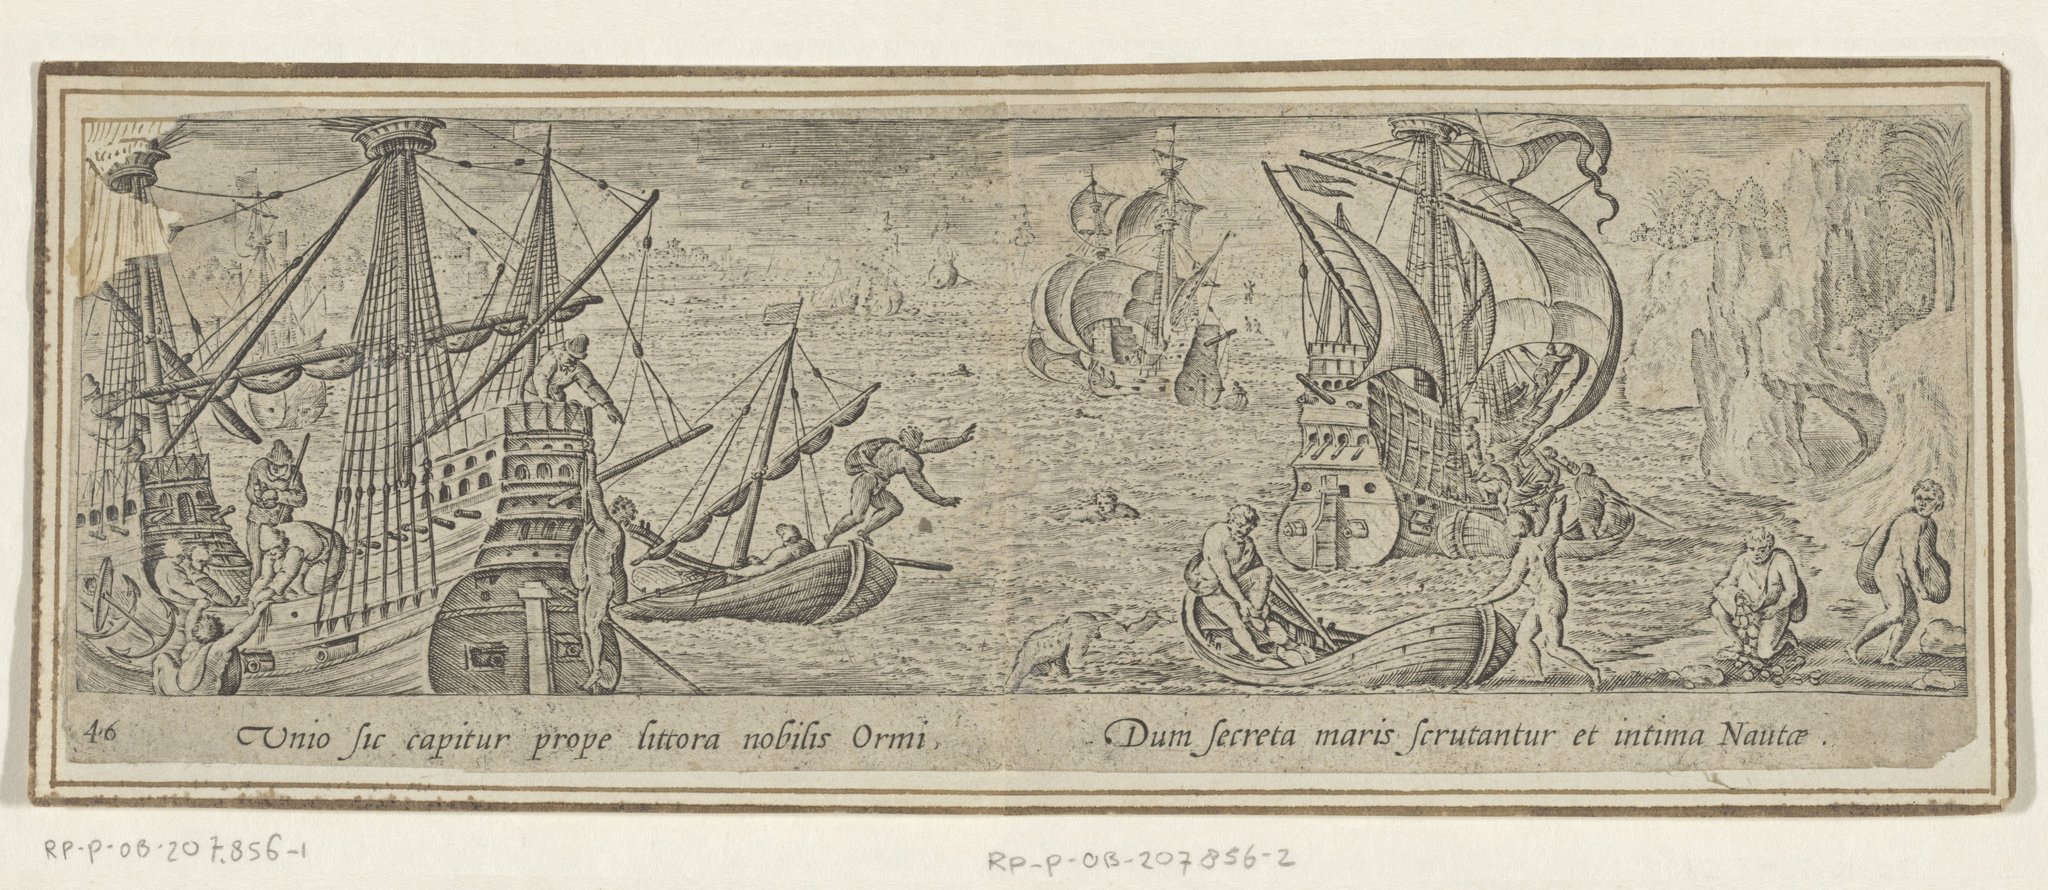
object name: print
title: Zeegezicht met driemaster en parelvissers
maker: adriaen collaert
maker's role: draughtsman, print maker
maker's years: 1560-1618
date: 1582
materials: paper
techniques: engraving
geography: southern netherlands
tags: ships (in general), pearl fishing, pearl diving; coral fishing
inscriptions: collector's mark: Lugt 2228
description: Prent maakt deel uit van een serie van 54 prenten met jachtscènes. Dit object is omwille van een betere presentatie virtueel samengevoegd maar bestaat fysiek uit losse onderdelen.